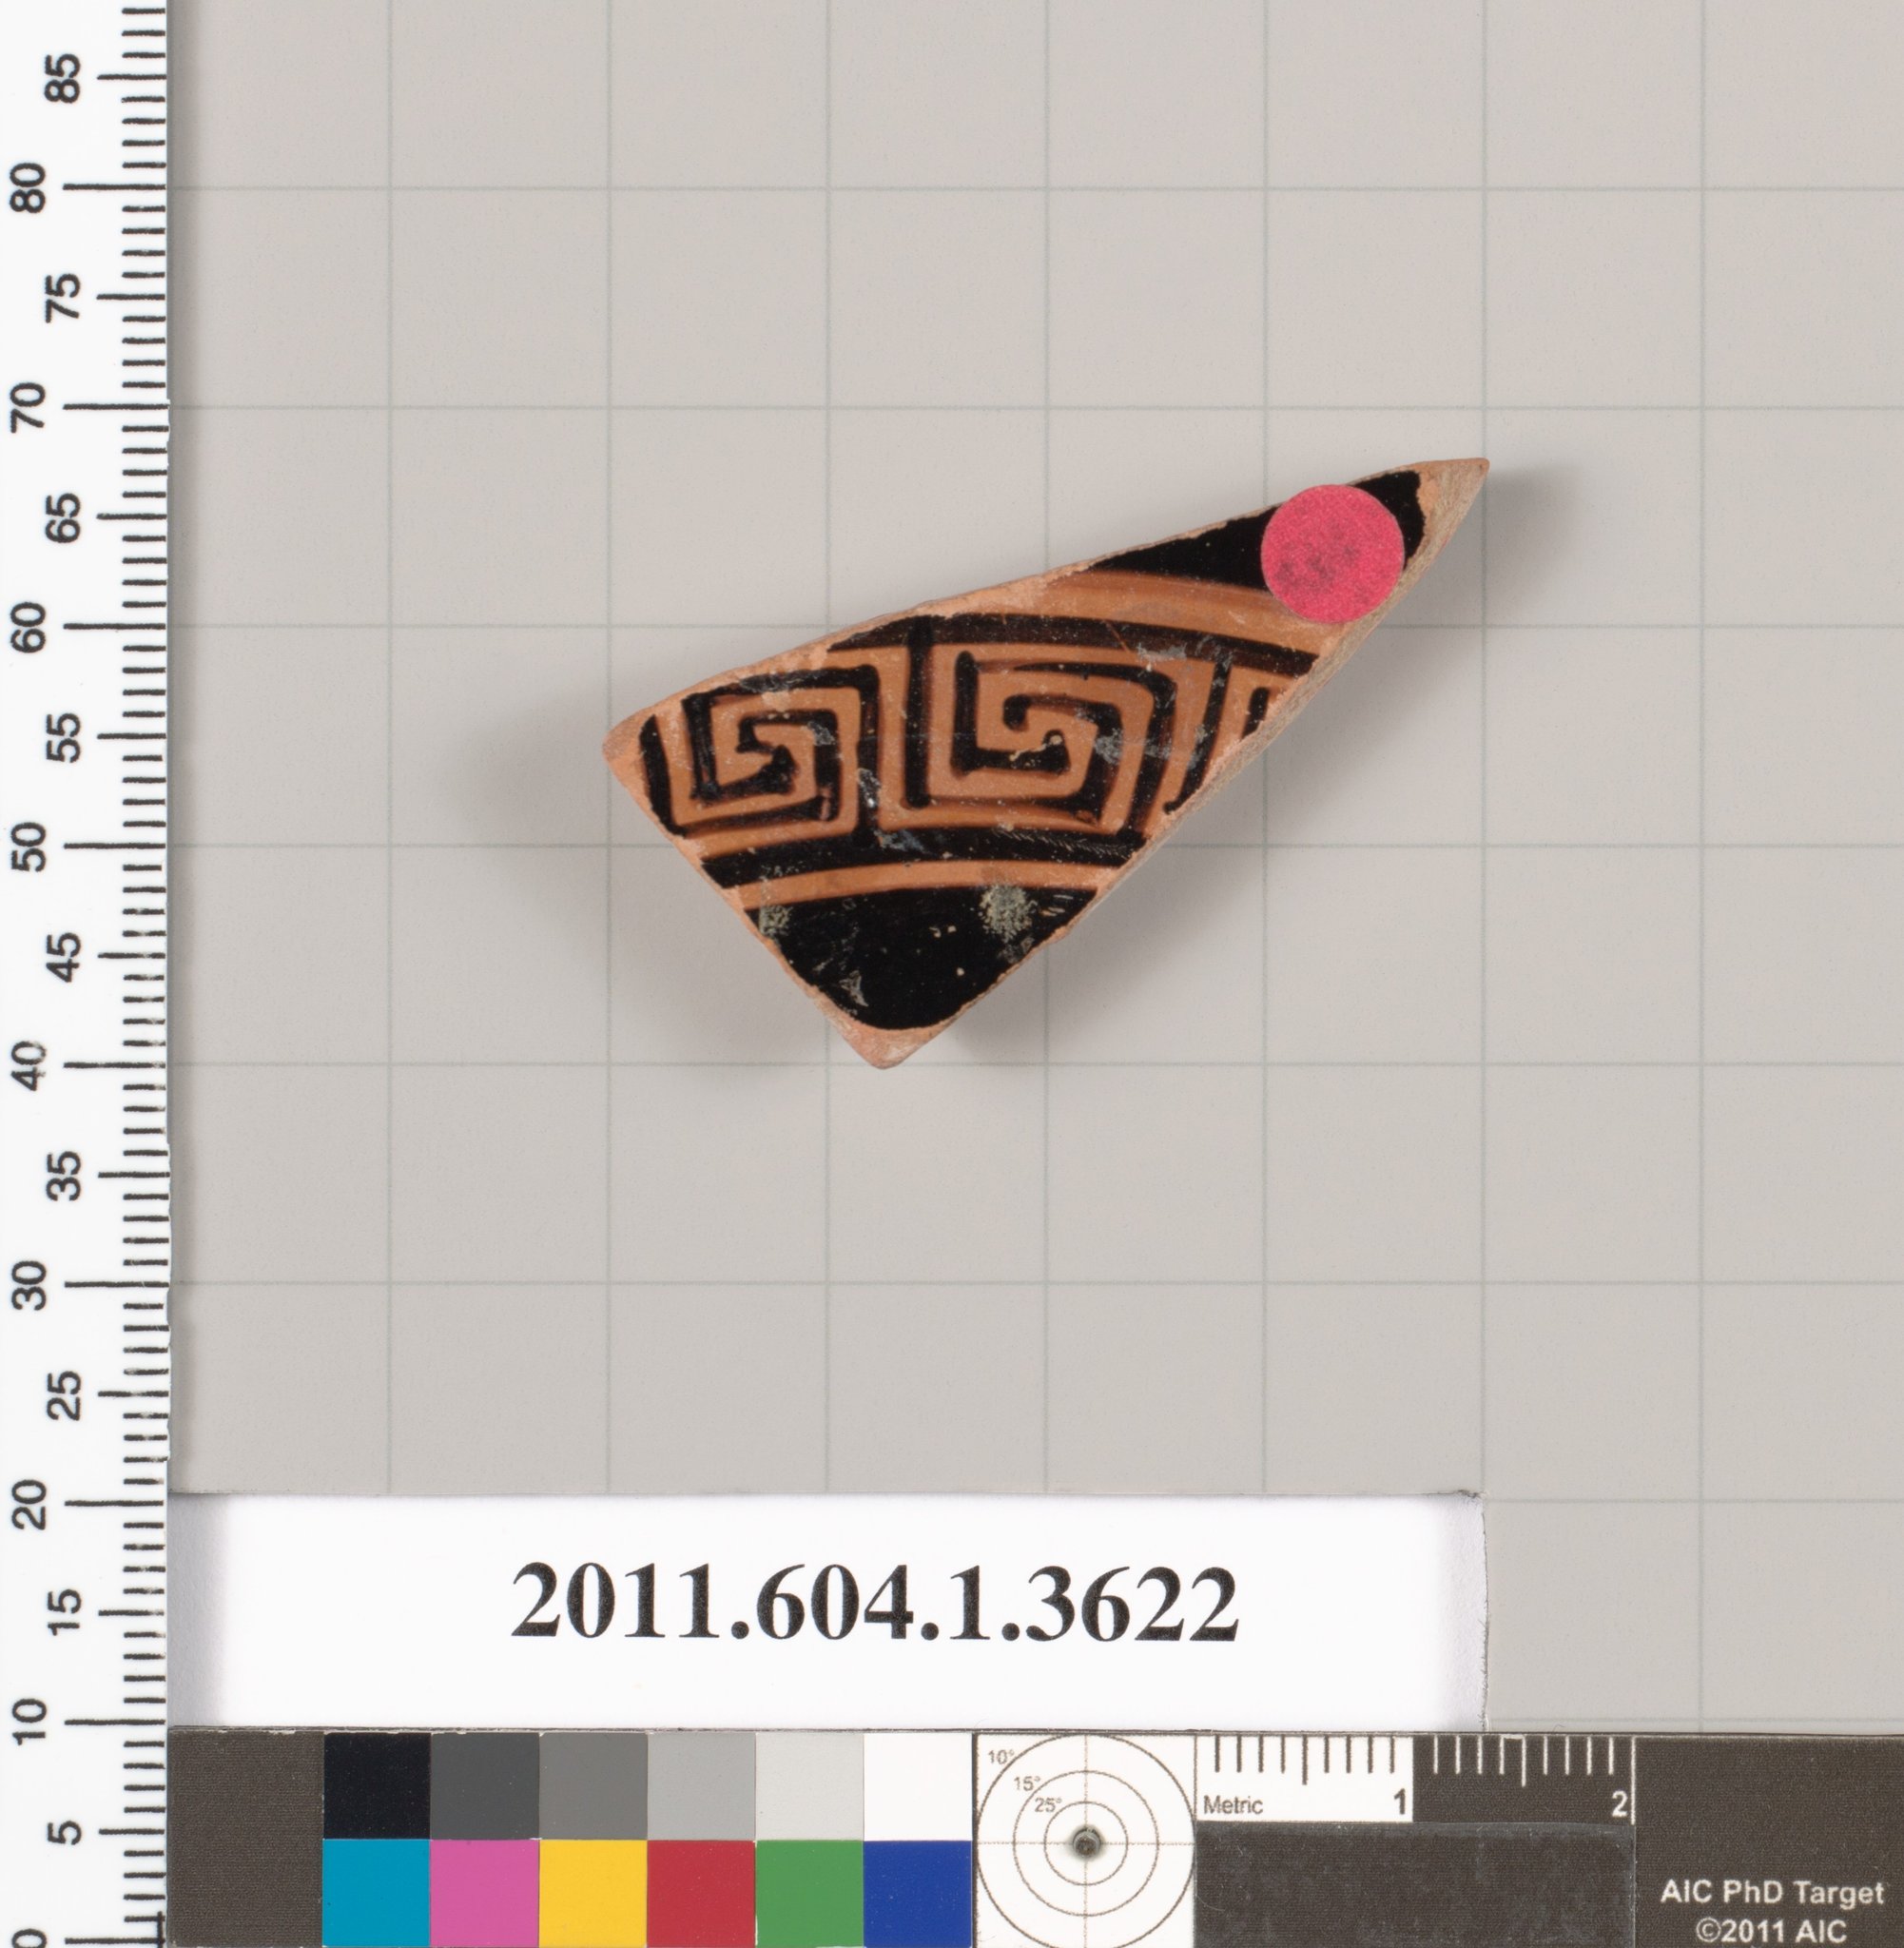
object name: kylix fragment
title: Terracotta fragment of a kylix (drinking cup)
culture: greek, attic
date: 475-451 BCE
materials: terracotta